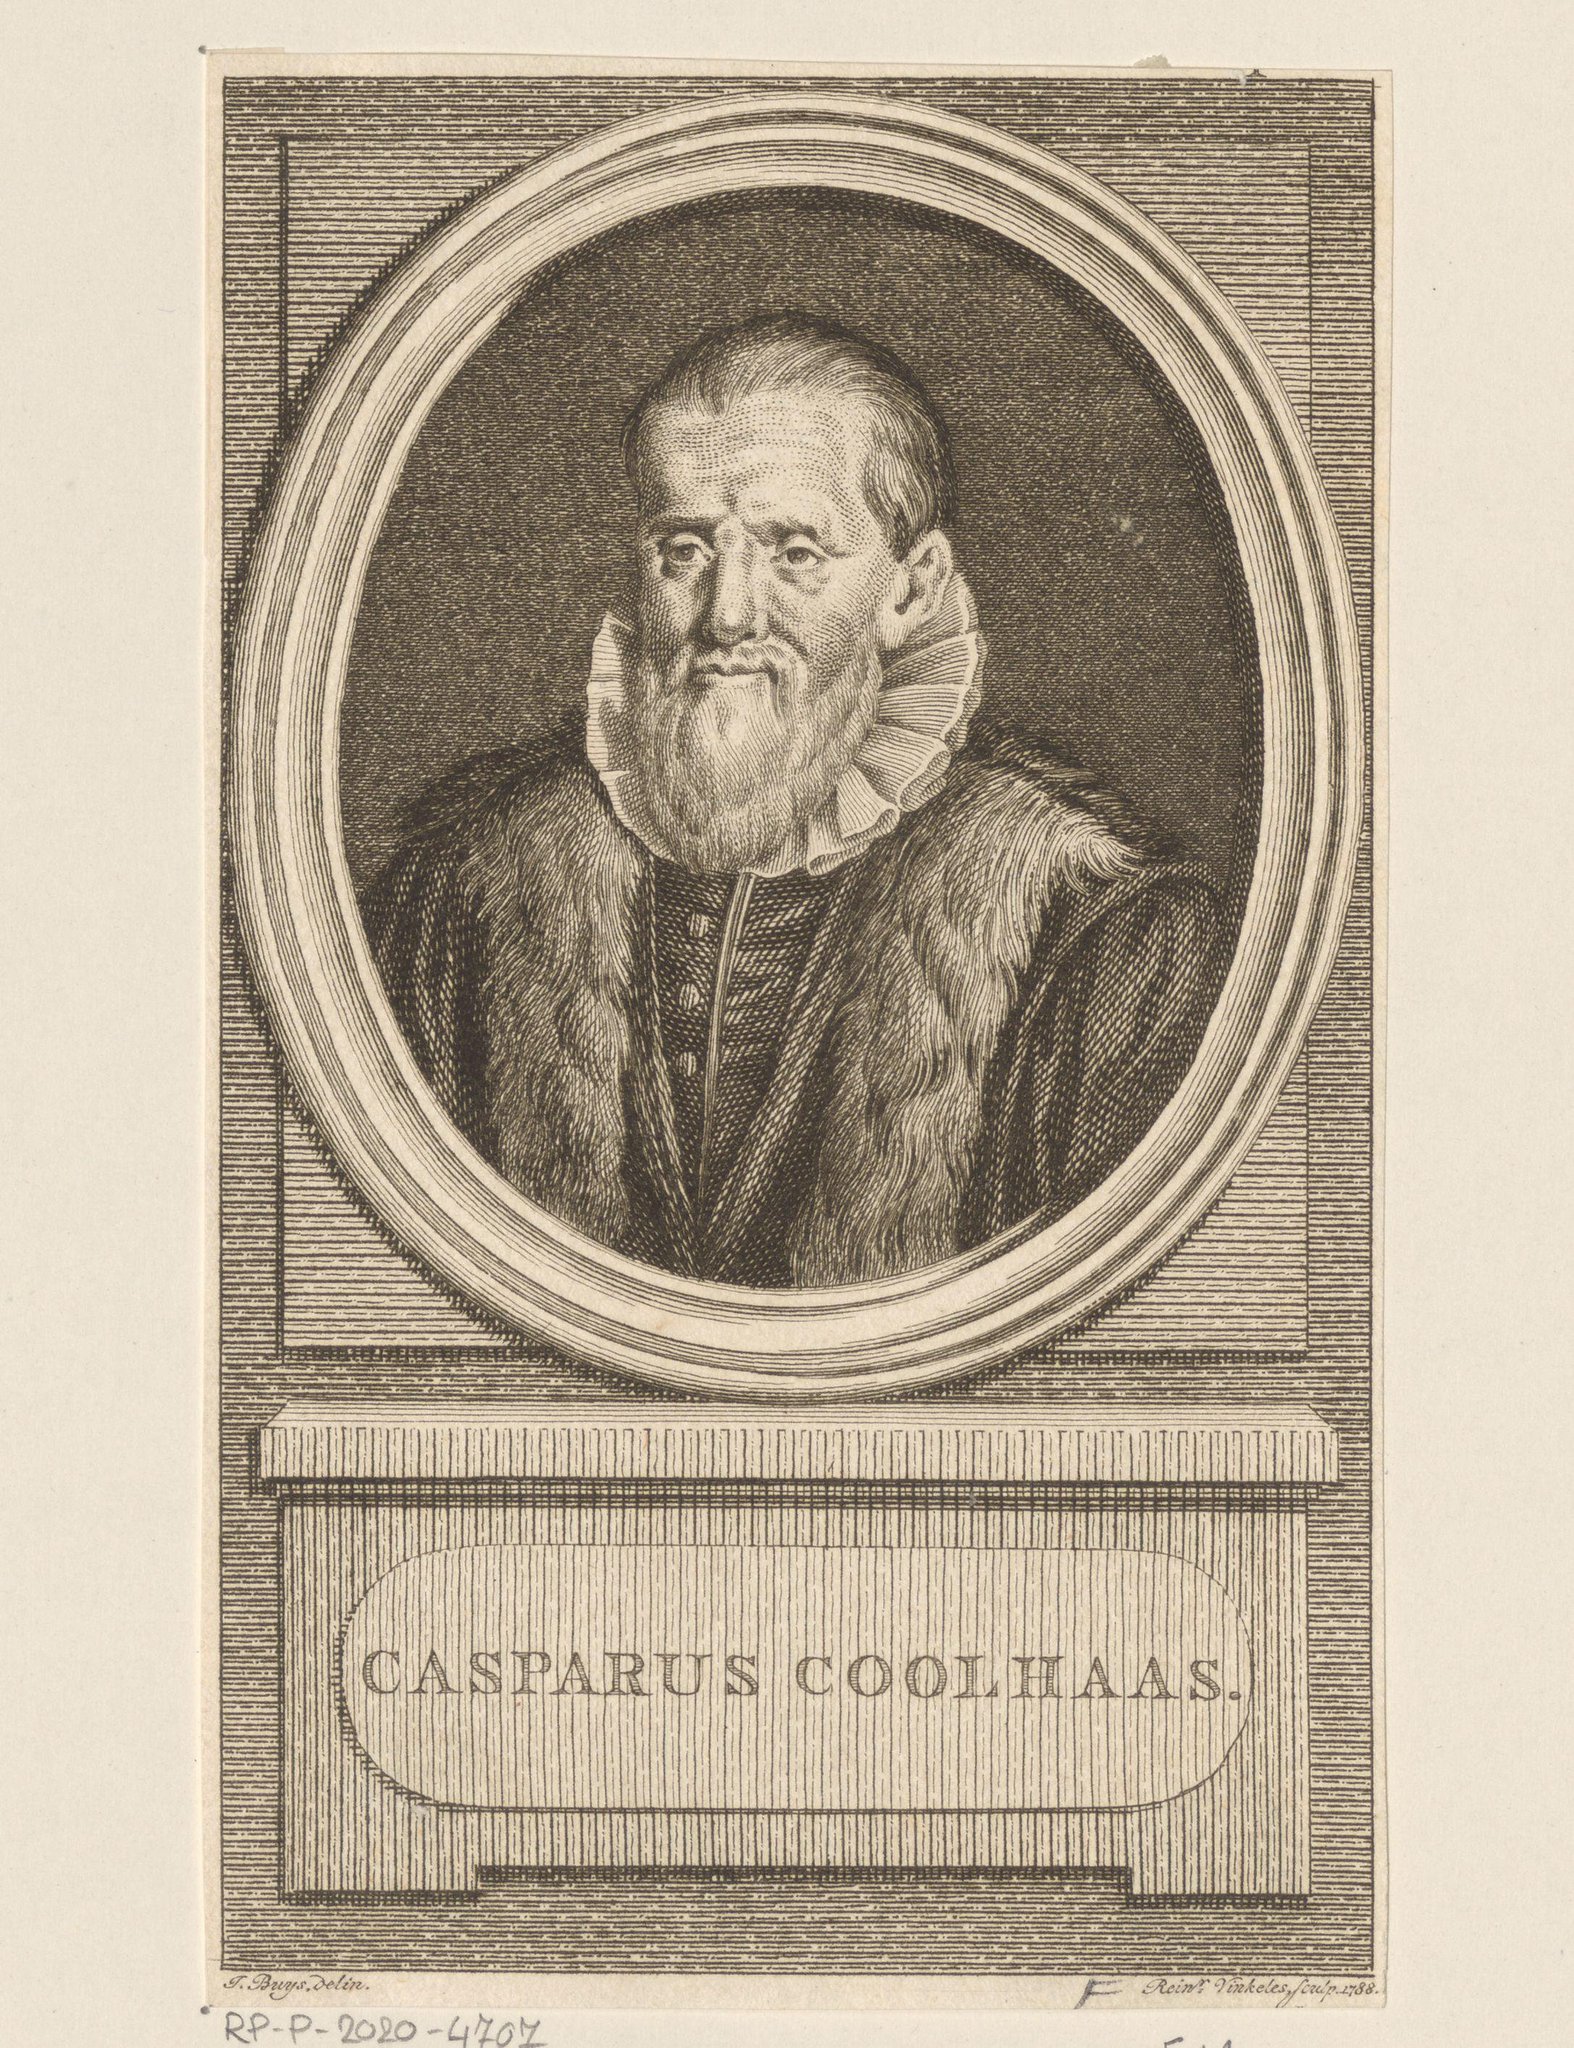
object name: print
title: Portret van Caspar Janszoon Coolhaes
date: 1788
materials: paper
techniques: engraving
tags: cologne, amsterdam, theologian, historical persons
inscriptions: date